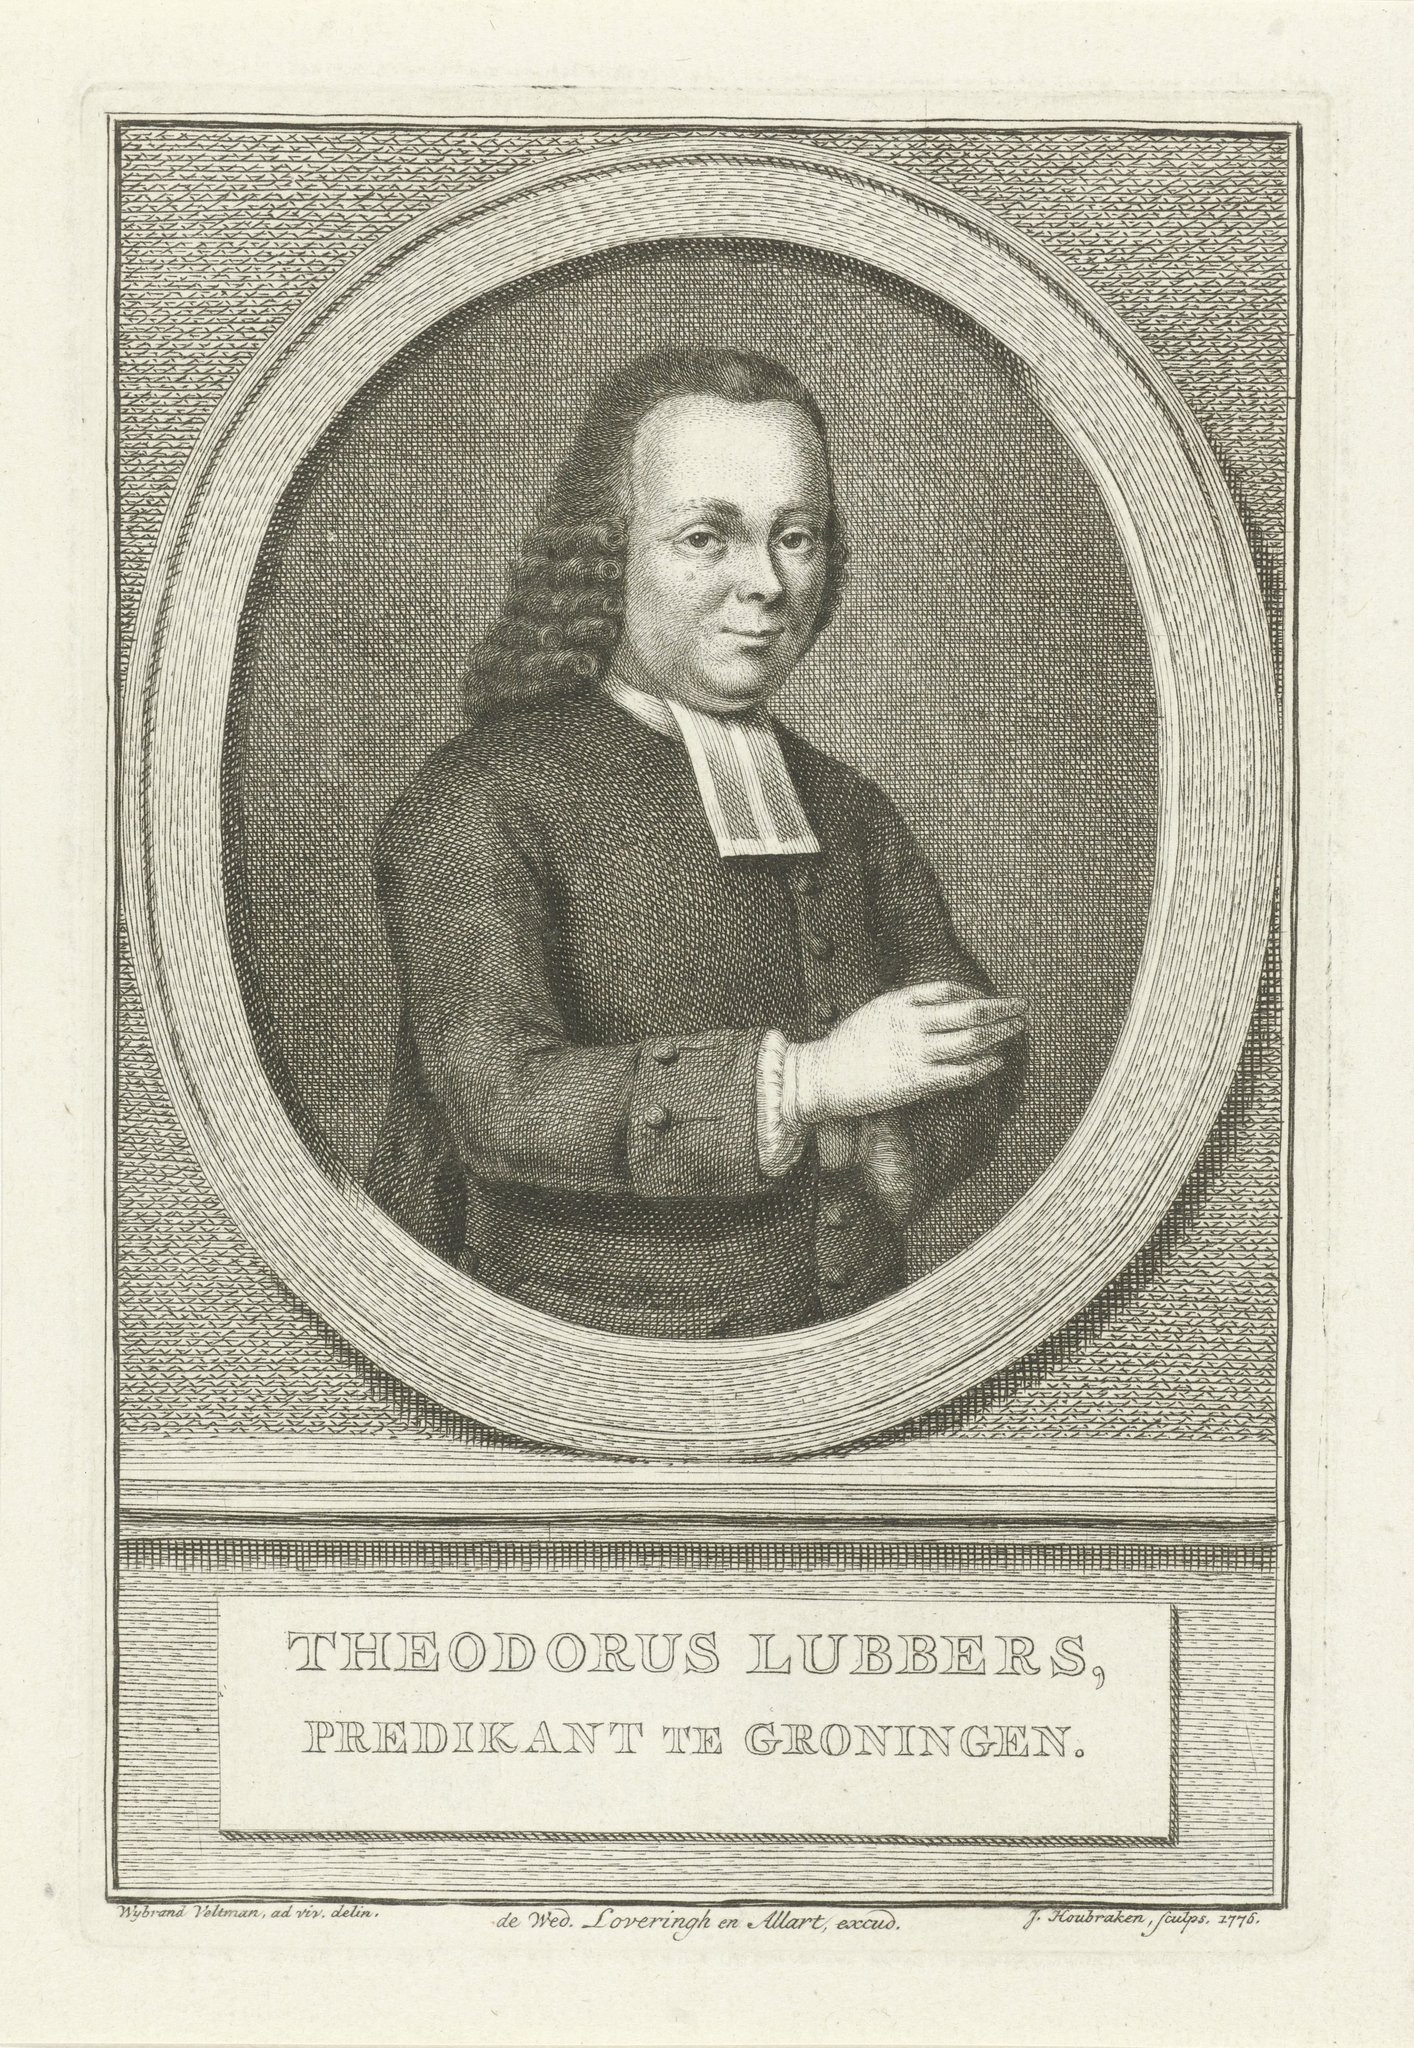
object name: print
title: Portret van Theodorus Lubbers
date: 1776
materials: paper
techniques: engraving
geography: amsterdam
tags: groningen, predikant, theodorus lubbers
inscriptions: collector's mark: Lugt 2228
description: Prent volgens Ver Huell ook gebruikt in: Josua van Iperen, Kerkelyke historie van het psalm-gezang der christenen (...) en inzonderheid van onze verbeterde Nederduitsche psalmberyminge. Amsterdam: wed. Loveringh en Allart, 1777. Deel 2: J. Allart, 1778.